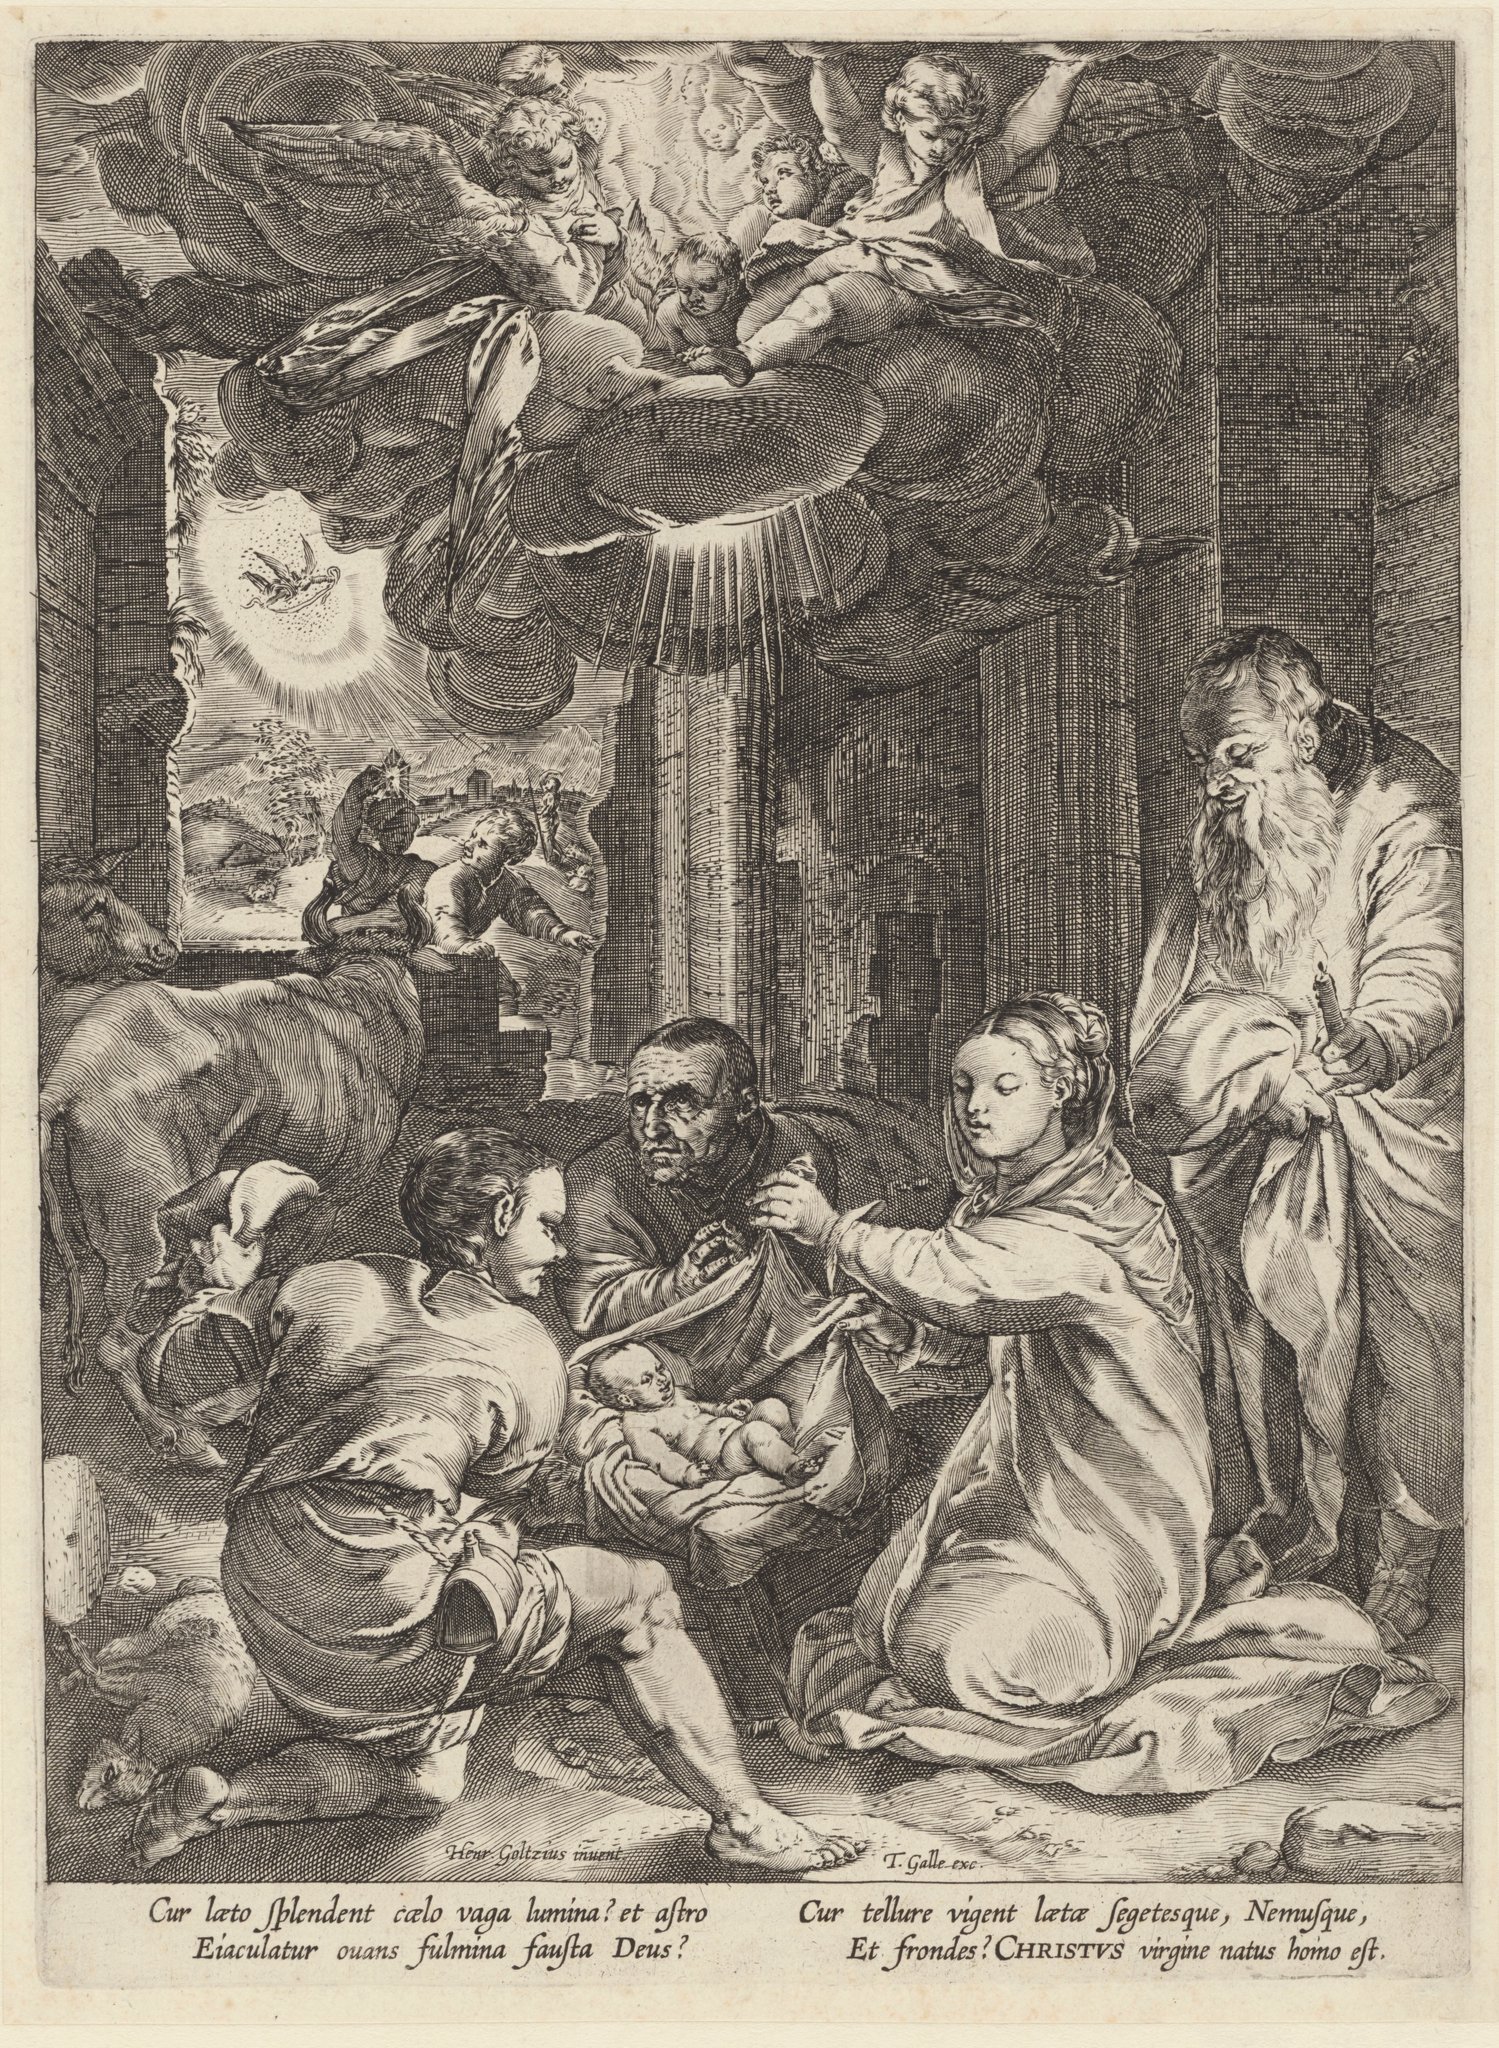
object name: print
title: De aanbidding der herders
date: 1594-1633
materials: paper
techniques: engraving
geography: antwerp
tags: adoration of the christ-child by the shepherds; mary and joseph present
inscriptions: collector's mark: Lugt 2228a, caption: ‘Cur laeto splendent coelo vaga lumina ? ......CHRISTUS virgine natus homo est.’, address: ‘T. Galle exc.’, signature: ‘Henr. Goltzius invent.’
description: Maria en Jozef tonen, gezeten in/bij een ruïne, hun pasgeboren kind aan twee herders. Op de achtergrond de verkondiging aan de herders door een engel. Onder de voorstelling vier Latijnse versregels.